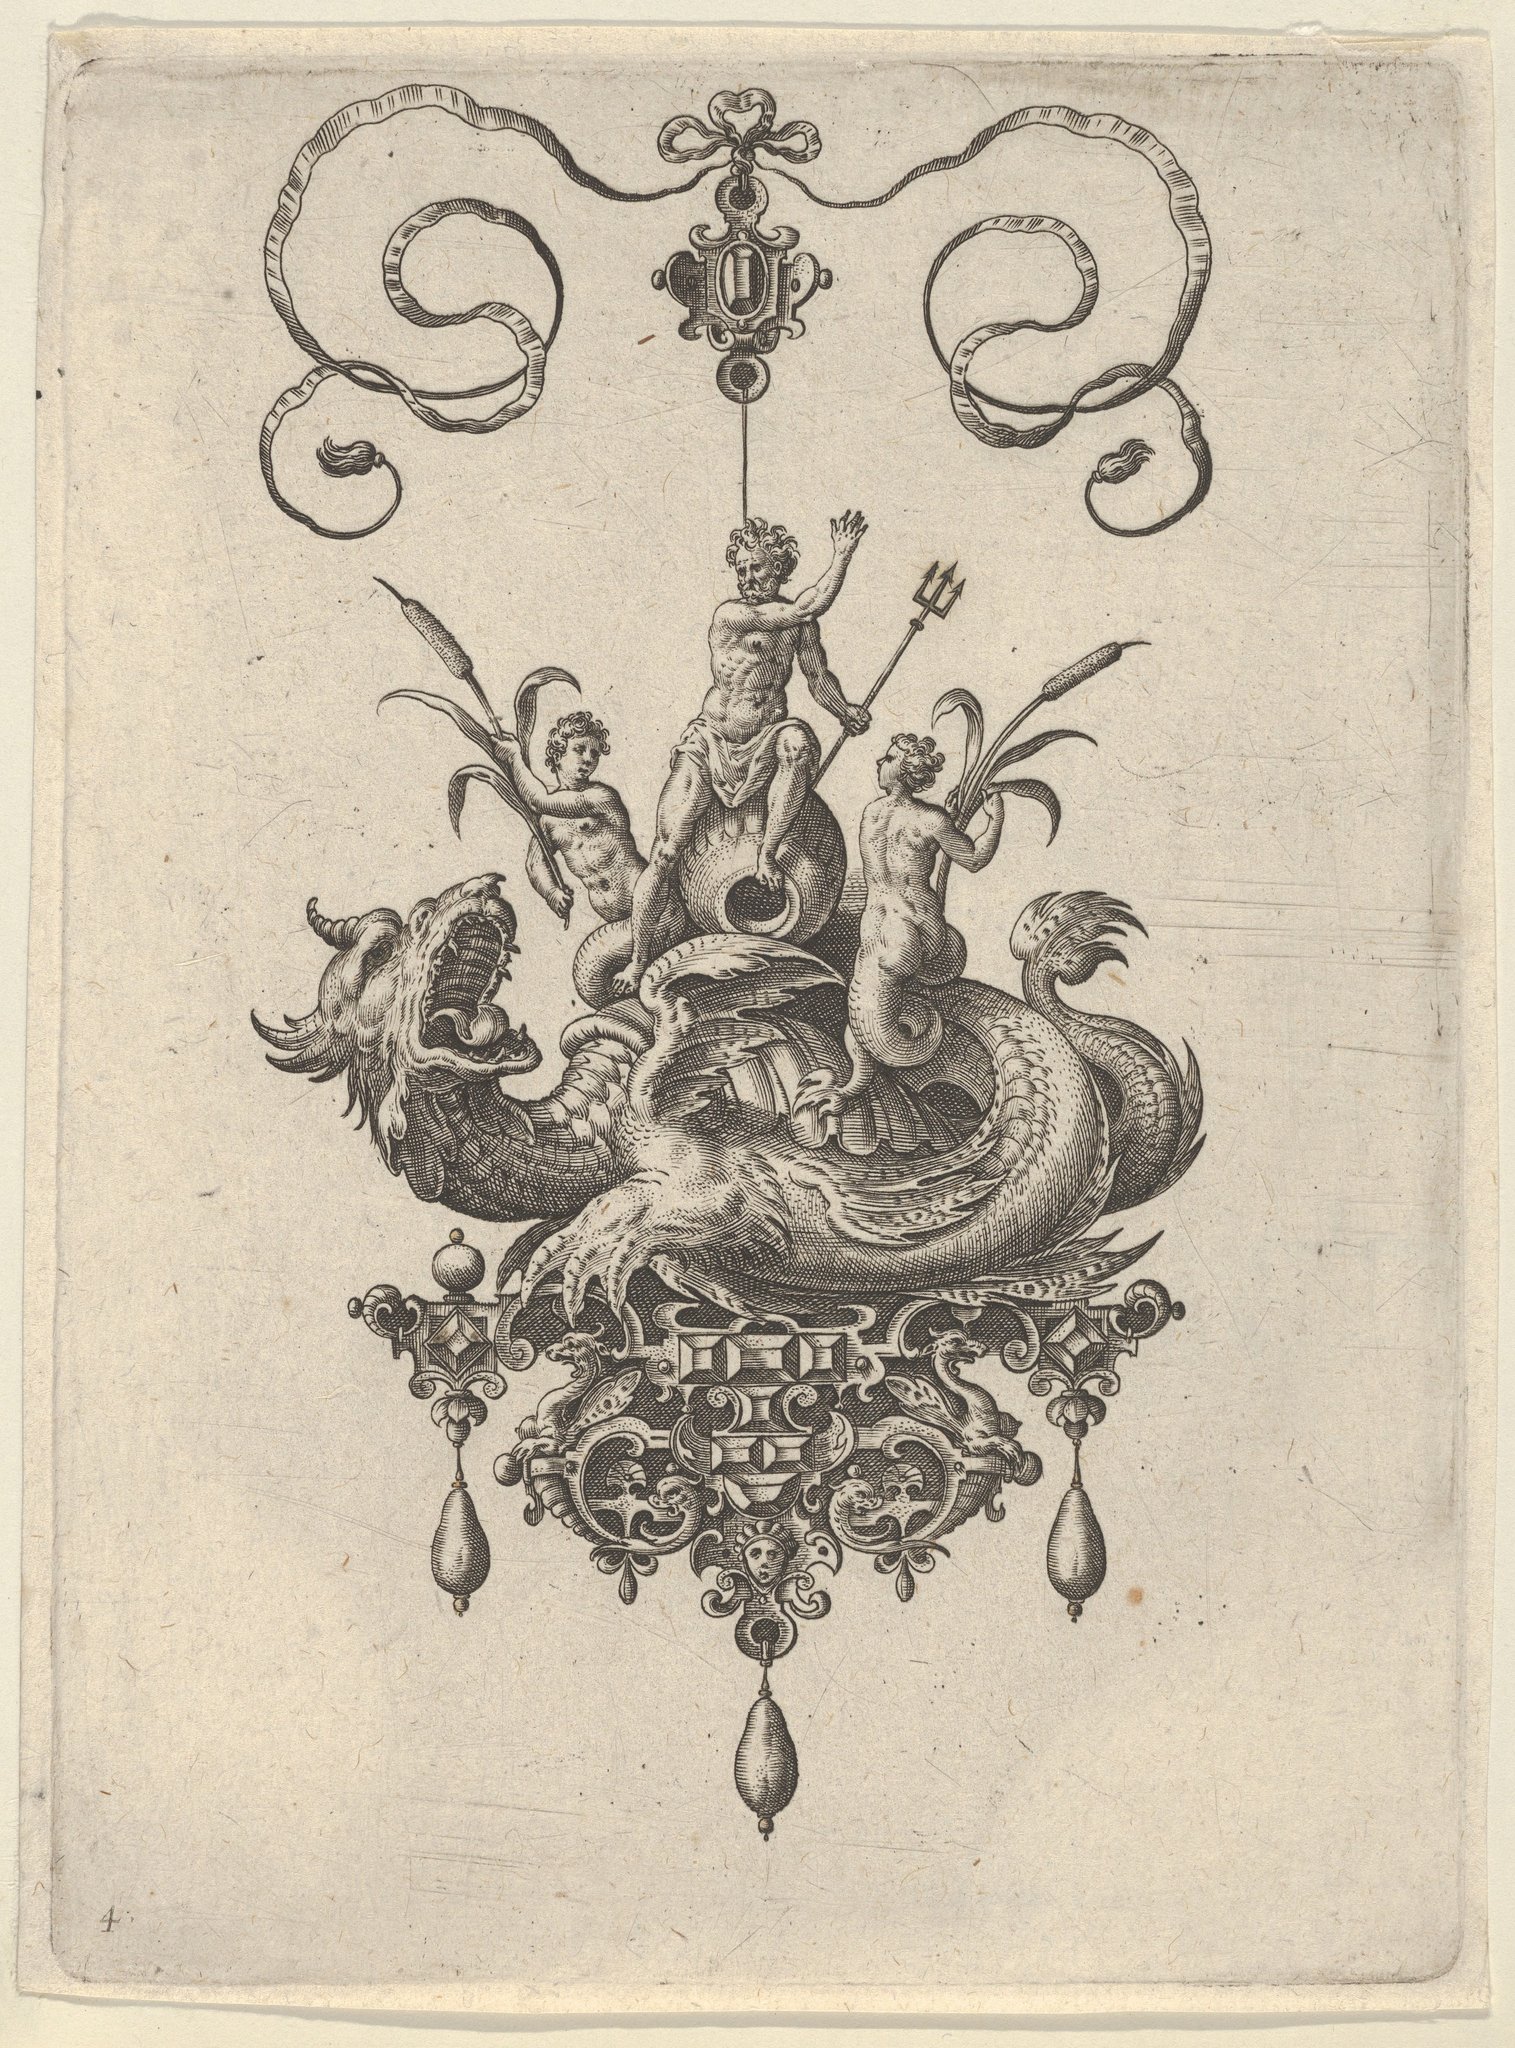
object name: print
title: Pendant Design with a Sea Monster Carrying Neptune Flanked by Two Nereids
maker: adriaen collaert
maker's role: artist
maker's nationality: netherlandish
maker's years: 1560-1618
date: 1582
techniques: engraving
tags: pendants,monsters,nymphs,neptune